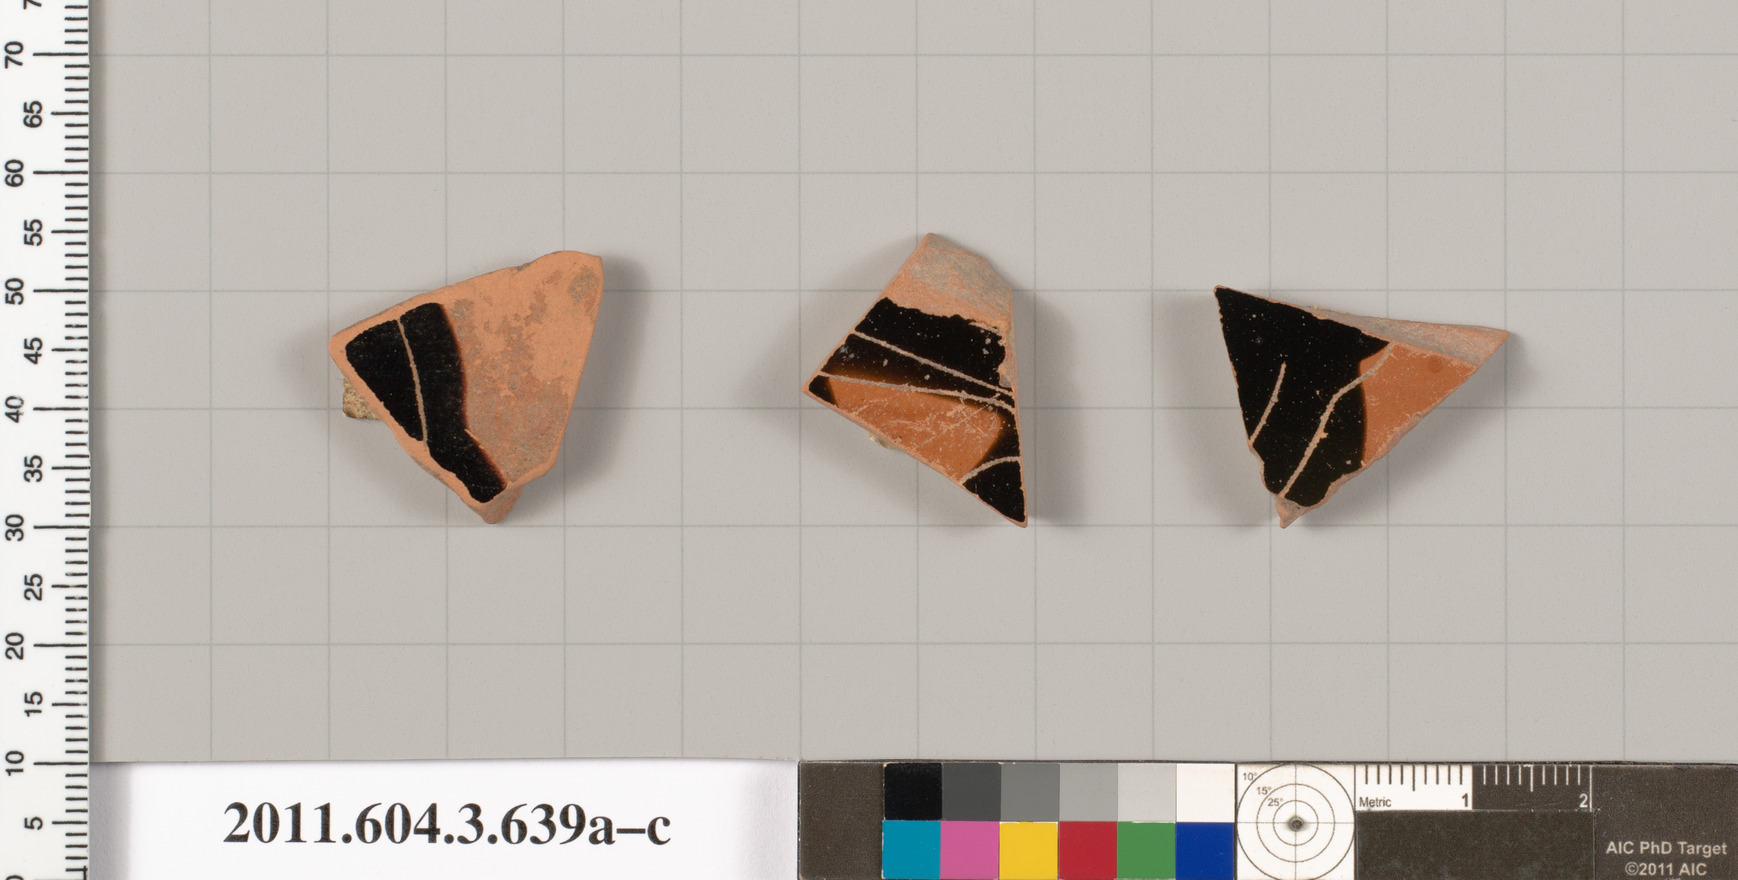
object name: calyx krater or column krater fragment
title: Terracotta fragments of calyx-kraters (bowls for mixing wine and water) or column-kraters (bowls for mixing wine and water)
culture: greek, attic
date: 534-468 BCE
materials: terracotta